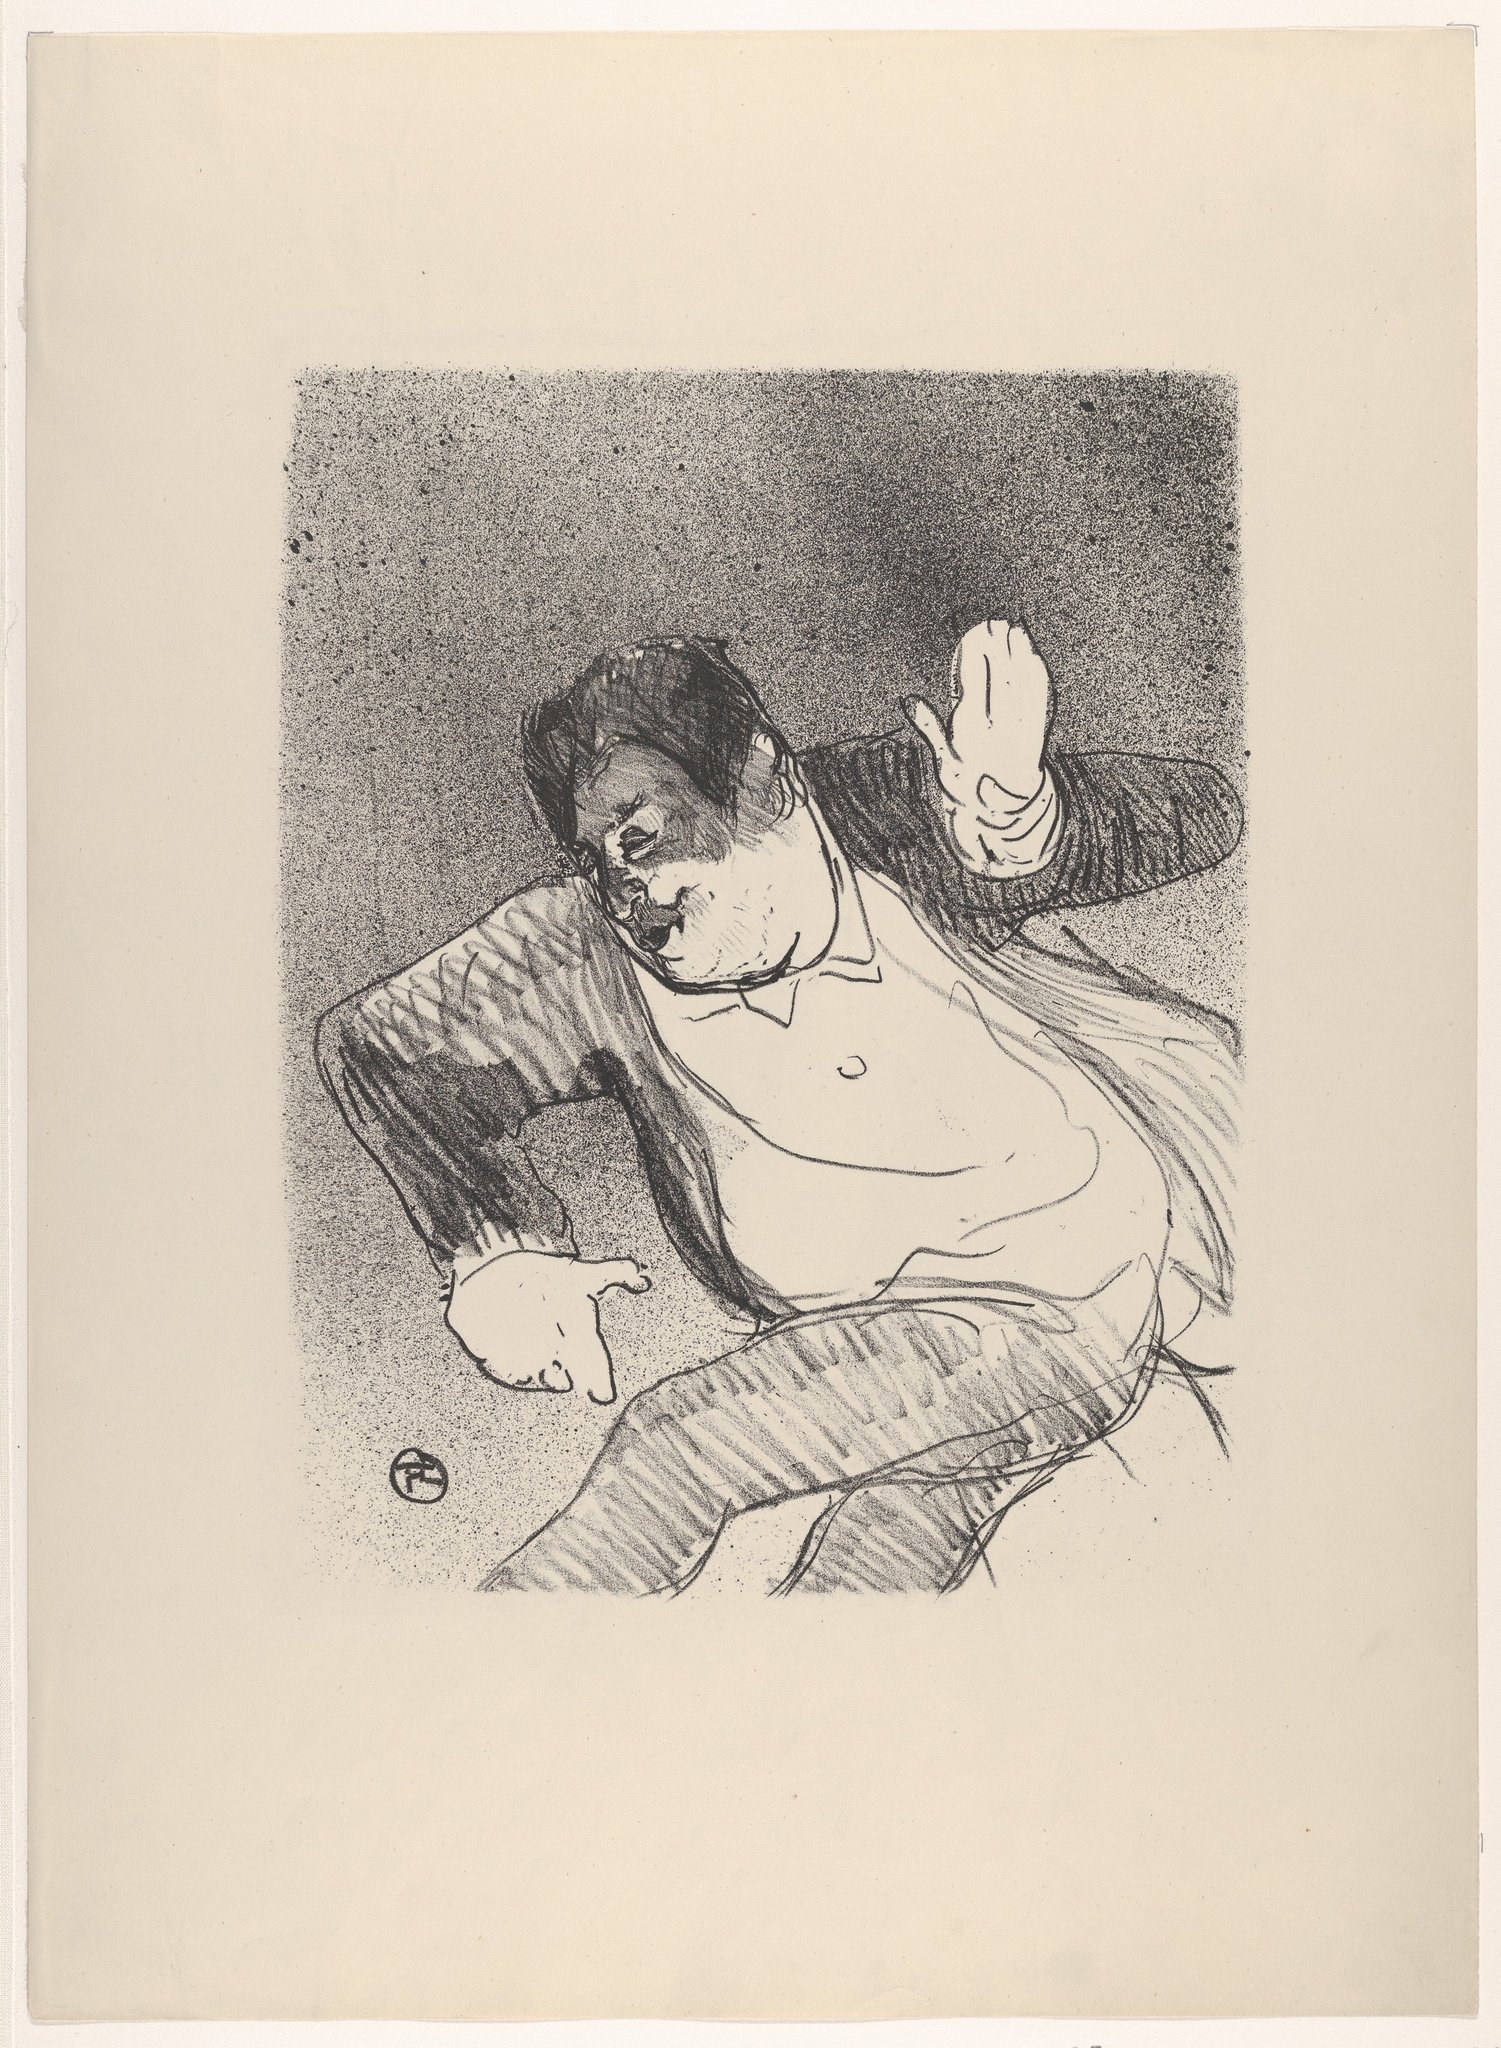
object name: print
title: Caudieux at the Petit Casino (from Le Café Concert)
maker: henri de toulouse-lautrec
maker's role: artist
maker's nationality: french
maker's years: 1864-1901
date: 1893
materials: crayon, paper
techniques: lithograph, printing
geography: france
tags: men